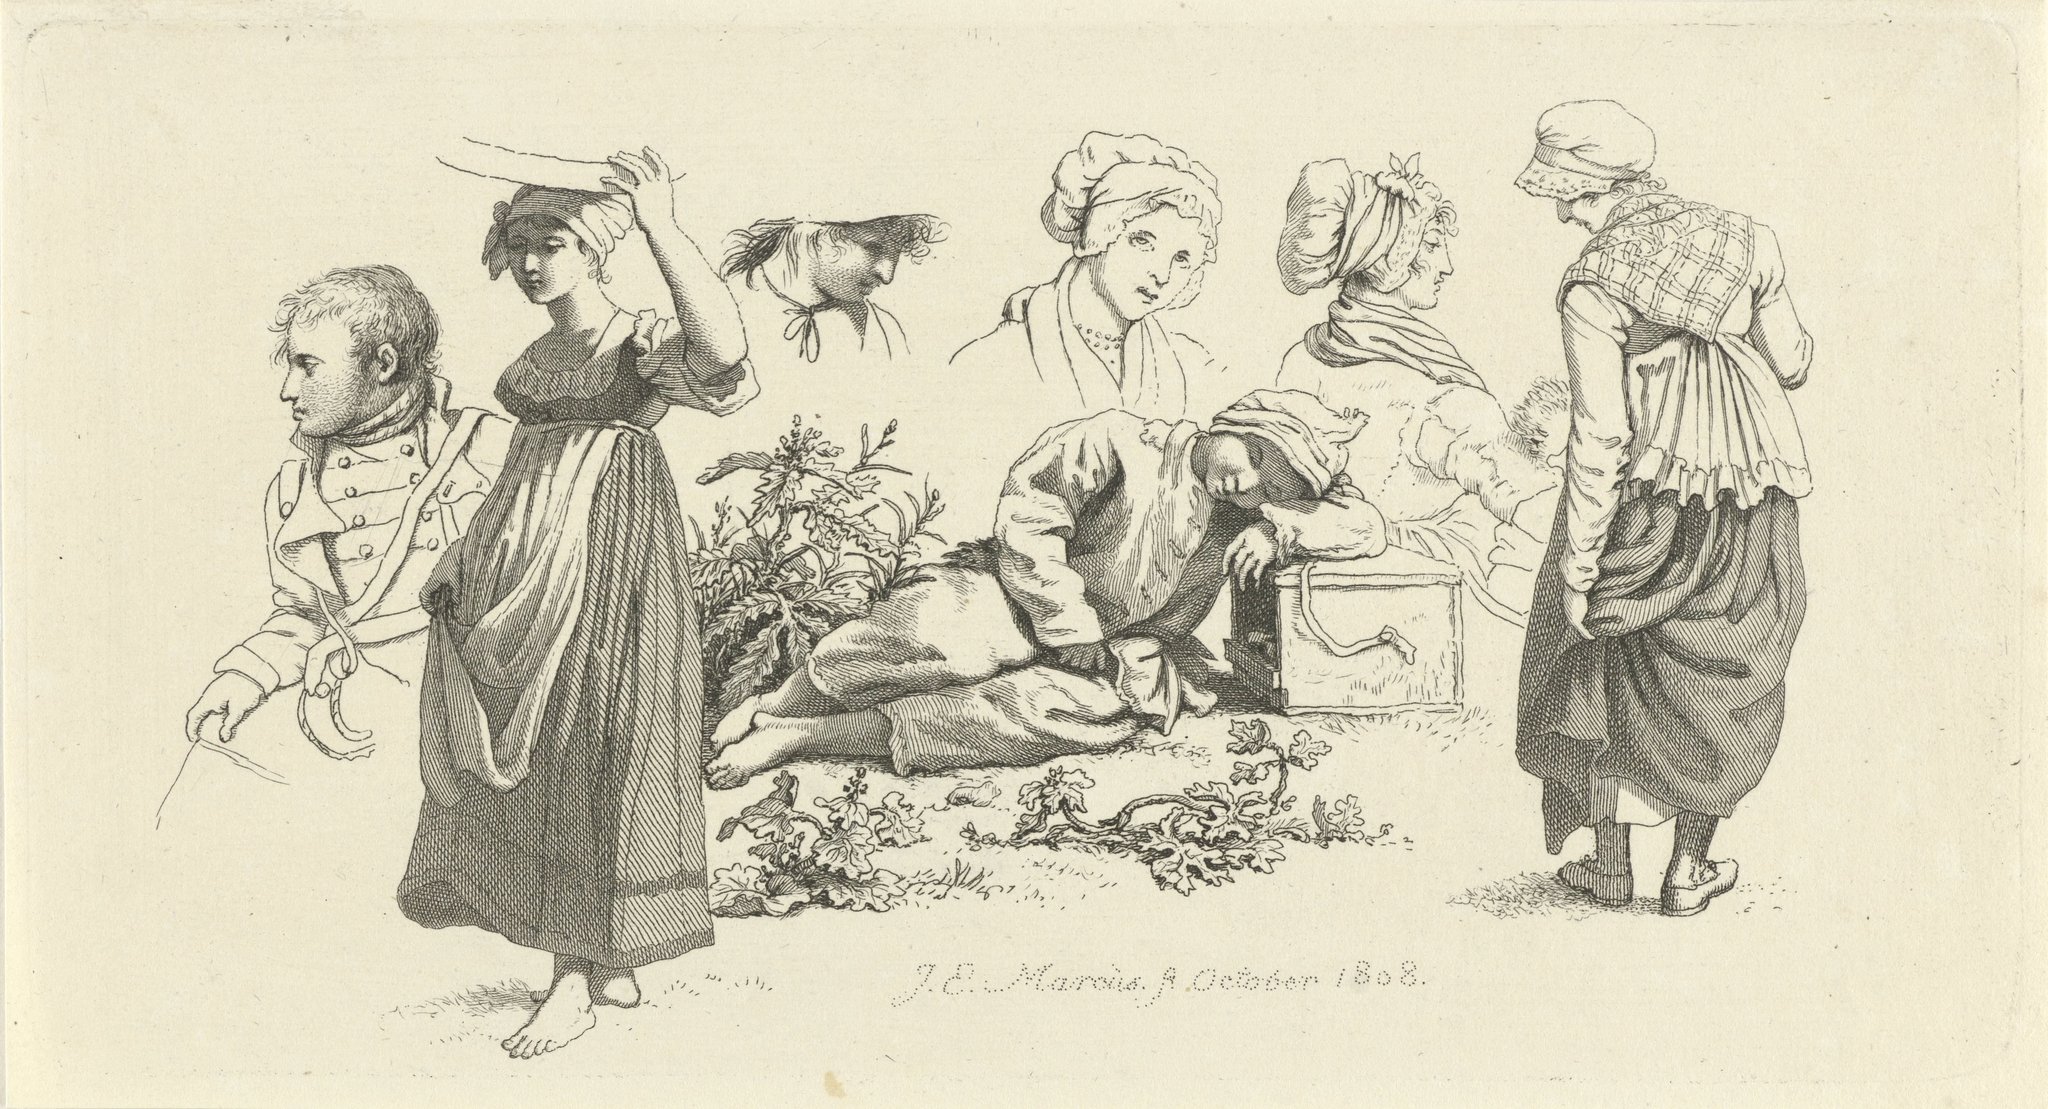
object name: print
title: Studie-prentwerk / Etudes gravées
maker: jacob ernst marcus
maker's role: draughtsman, print maker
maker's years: 1774-1826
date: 1808-1810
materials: paper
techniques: etching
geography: amsterdam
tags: adolescent, young woman, maiden, sleeping on the ground - bb - out of doors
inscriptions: collector's mark: Lugt 2228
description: Serie voor het eerst uitgegeven door Jacob Ernst Marcus onder de titel Studiebeelden en Fragmenten. Amsterdam: ca.1816. Later heruitgegeven als: Studie-prentwerk/ Etudes gravées.